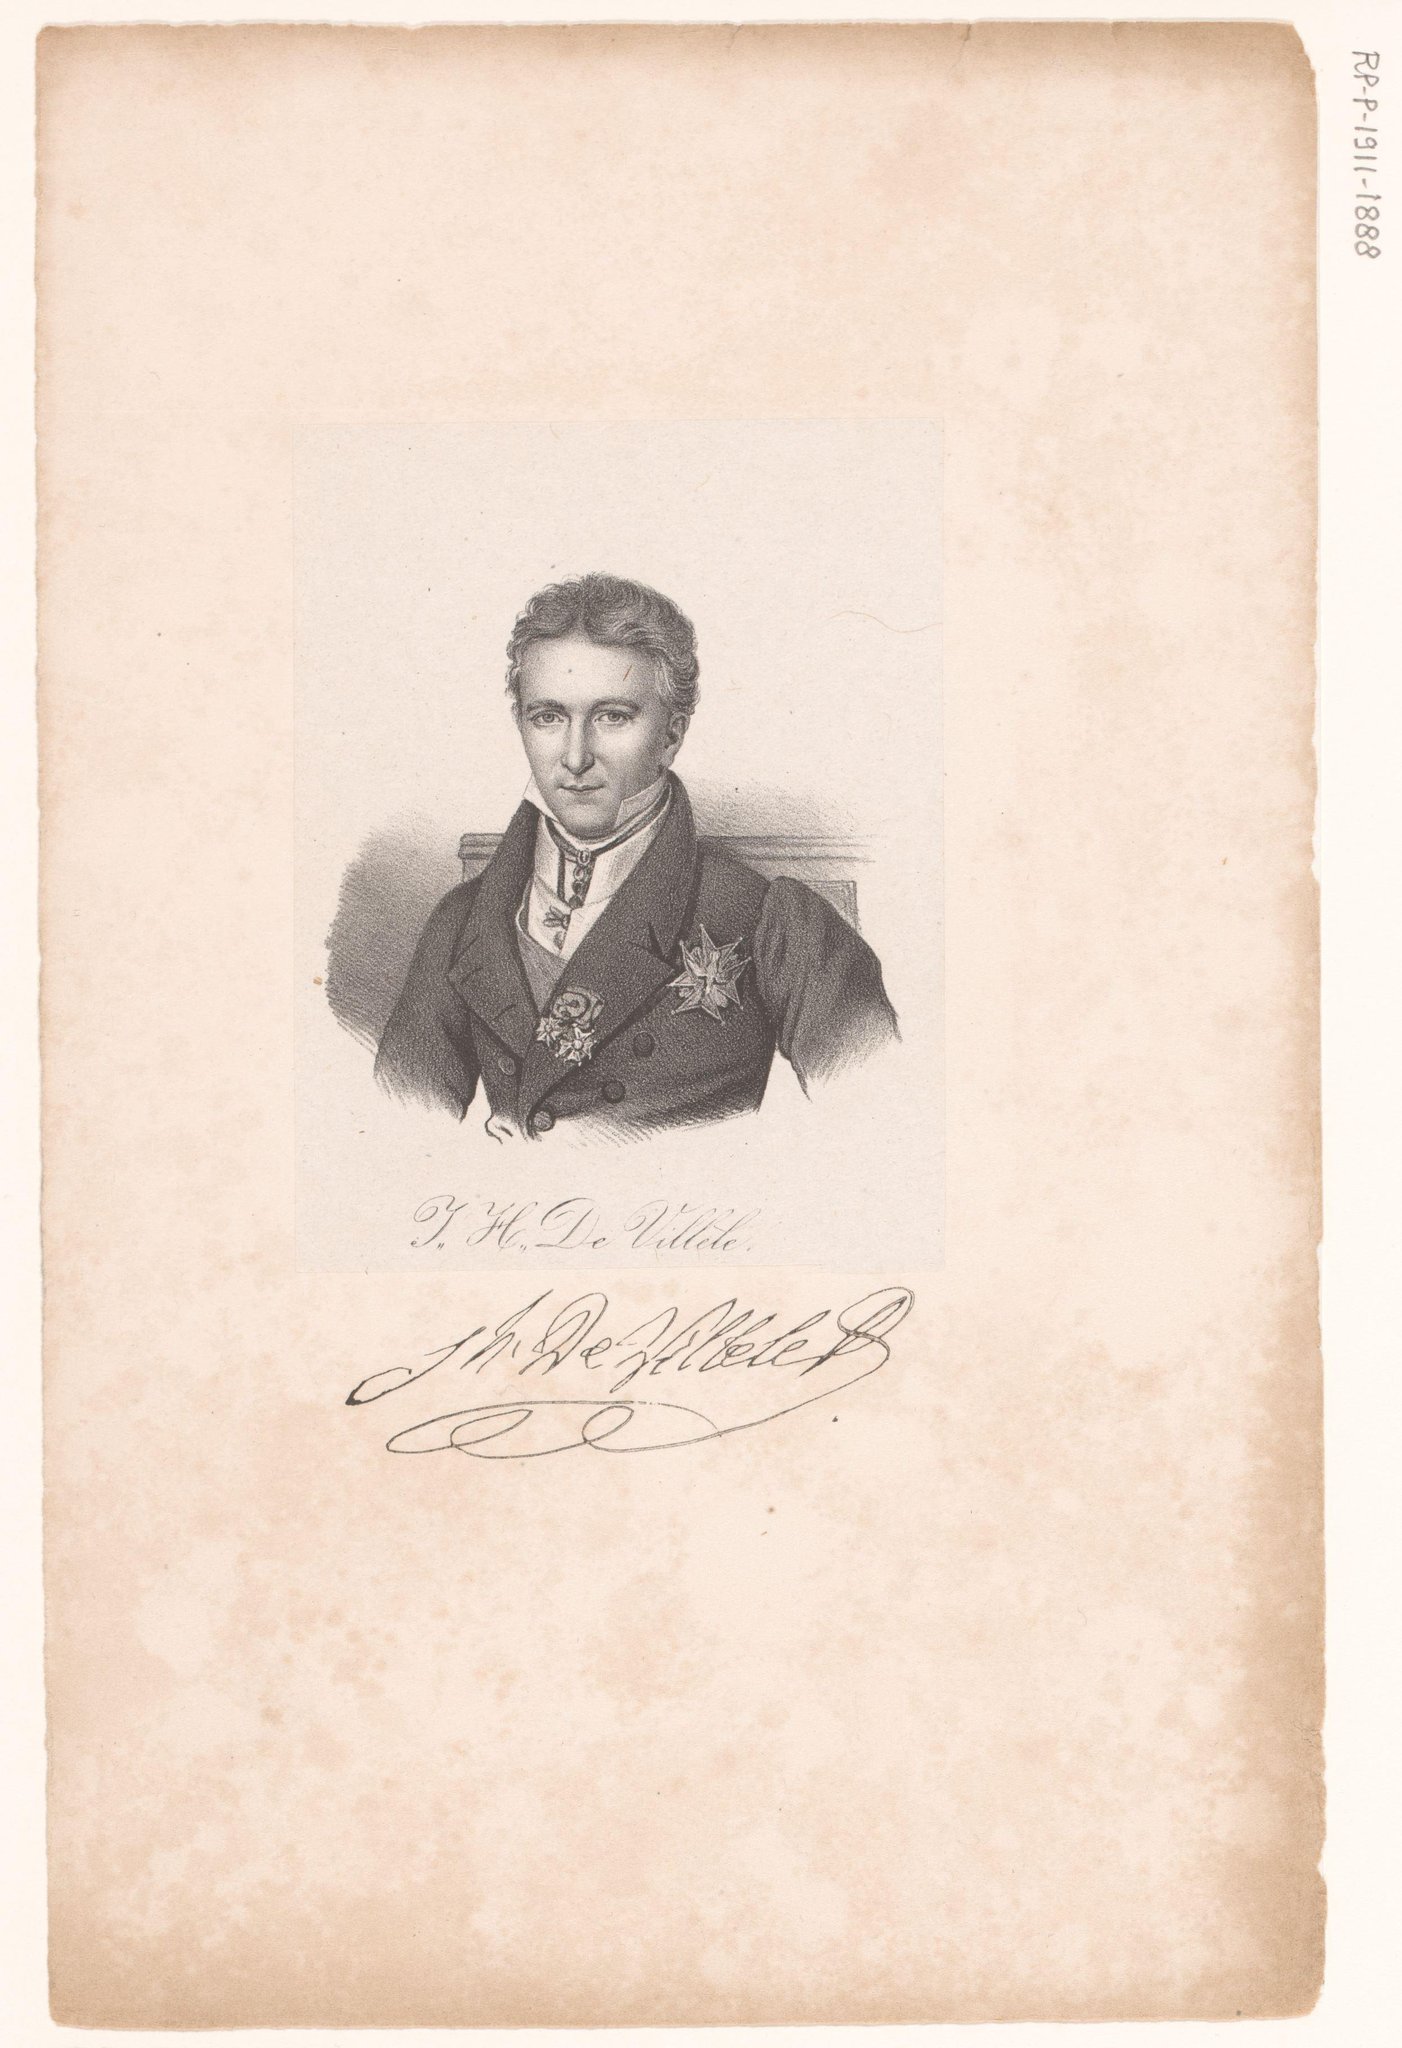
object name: print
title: Portret van Joseph de Villèle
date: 1818-1842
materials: paper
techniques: lithograph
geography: paris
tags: politician, mayor, historical persons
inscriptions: collector's mark: Lugt 2228a